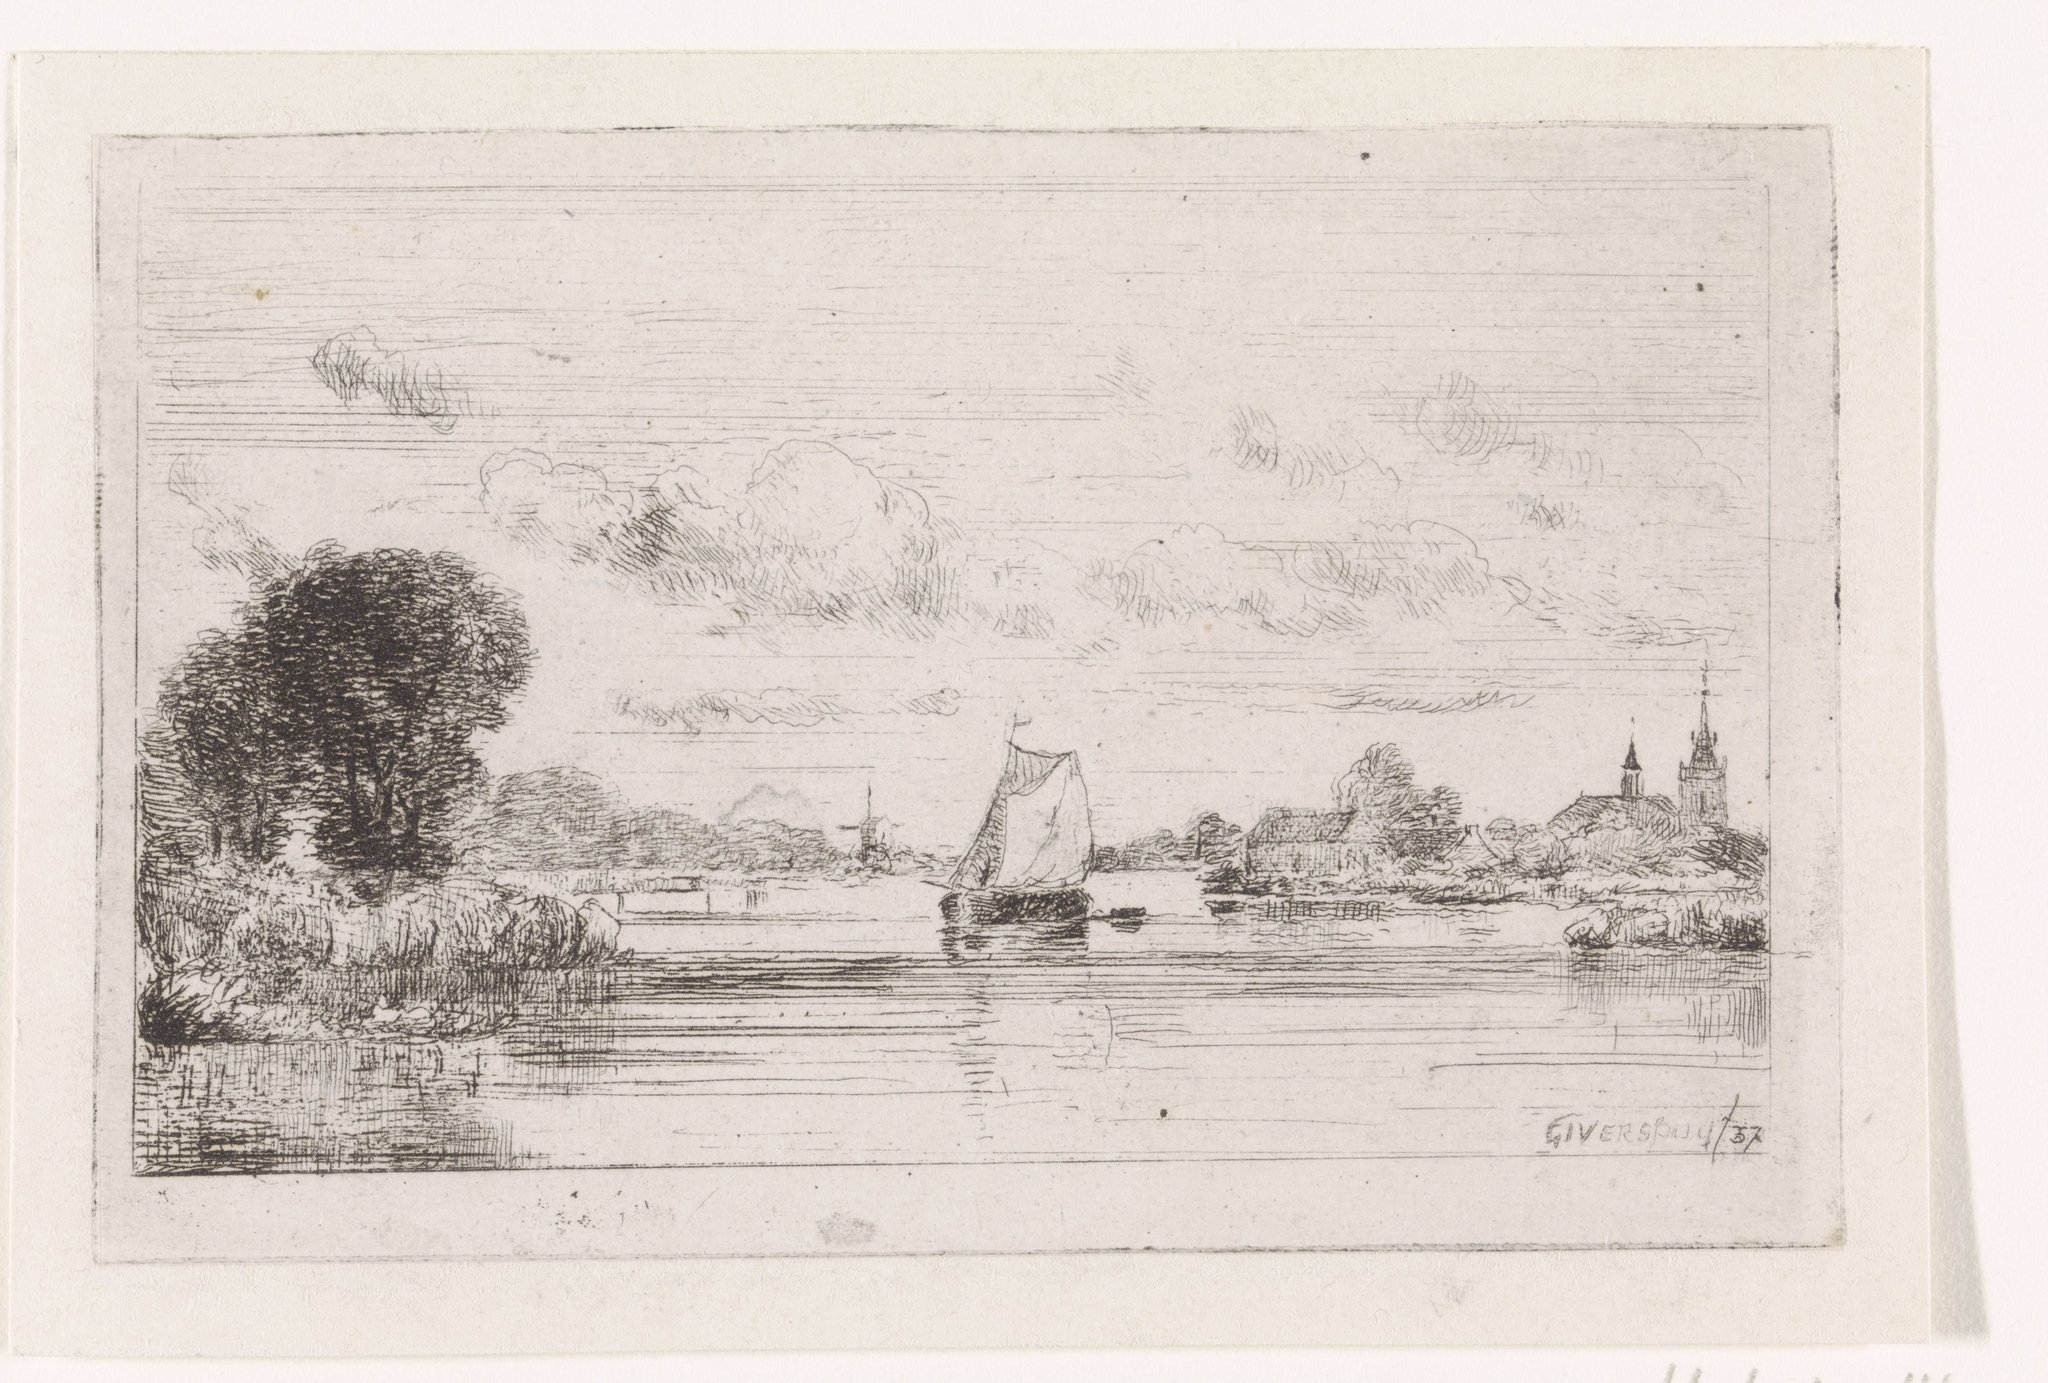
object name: print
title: Zeilschip nabij een dorp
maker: gijsbertus johannes verspuy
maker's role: print maker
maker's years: 1823-1862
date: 1857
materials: paper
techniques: etching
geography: netherlands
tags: sailing-ship, sailing-boat, river, windmill in landscape, parts of church exterior and annexes: tower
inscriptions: collector's mark: Lugt 2228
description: Een zeilschip op een rivier met op de rechteroever een dorp. In de verte een molen.